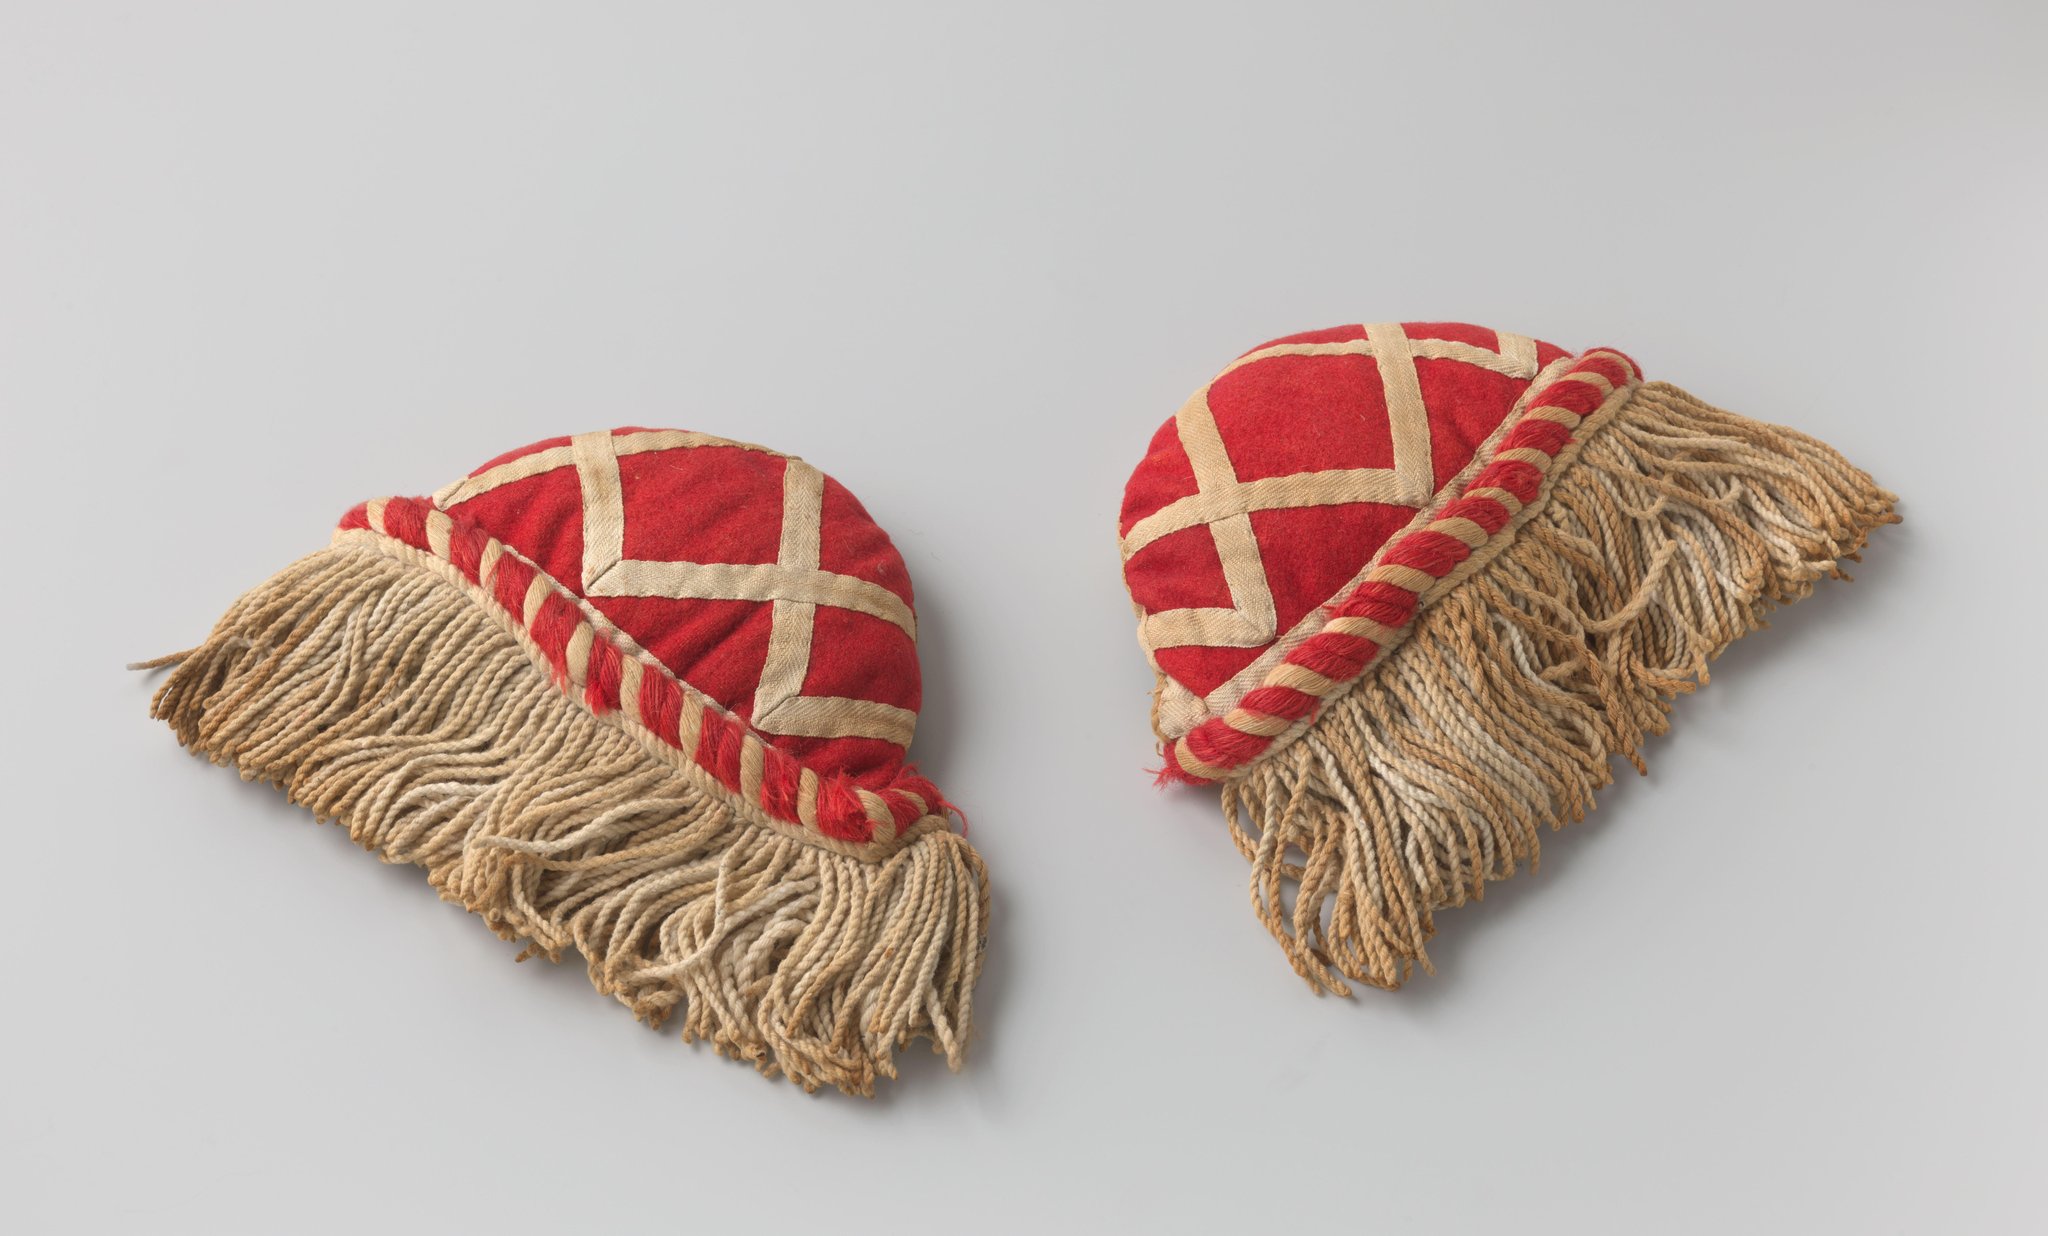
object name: zwaluwnest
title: Zwaluwnest van tamboer of hoornblazer der infanterie-schutterij, buitenmodel ca. 1890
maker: Anonymous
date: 1890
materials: textile, wool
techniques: stitching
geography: netherlands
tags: netherlands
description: Zwaluwnest tamboer of hoornblazer der dienstdoende infanterie-schutterij, buitenmodel. Halfronde rode lakense schouder bedekking, met wit galon afgezet en gekruiste galon op het rode laken, Aan de onderzijde witrood koord. Groen-wit franje, sterke verkleuringen in de stof. Zwarte voering.